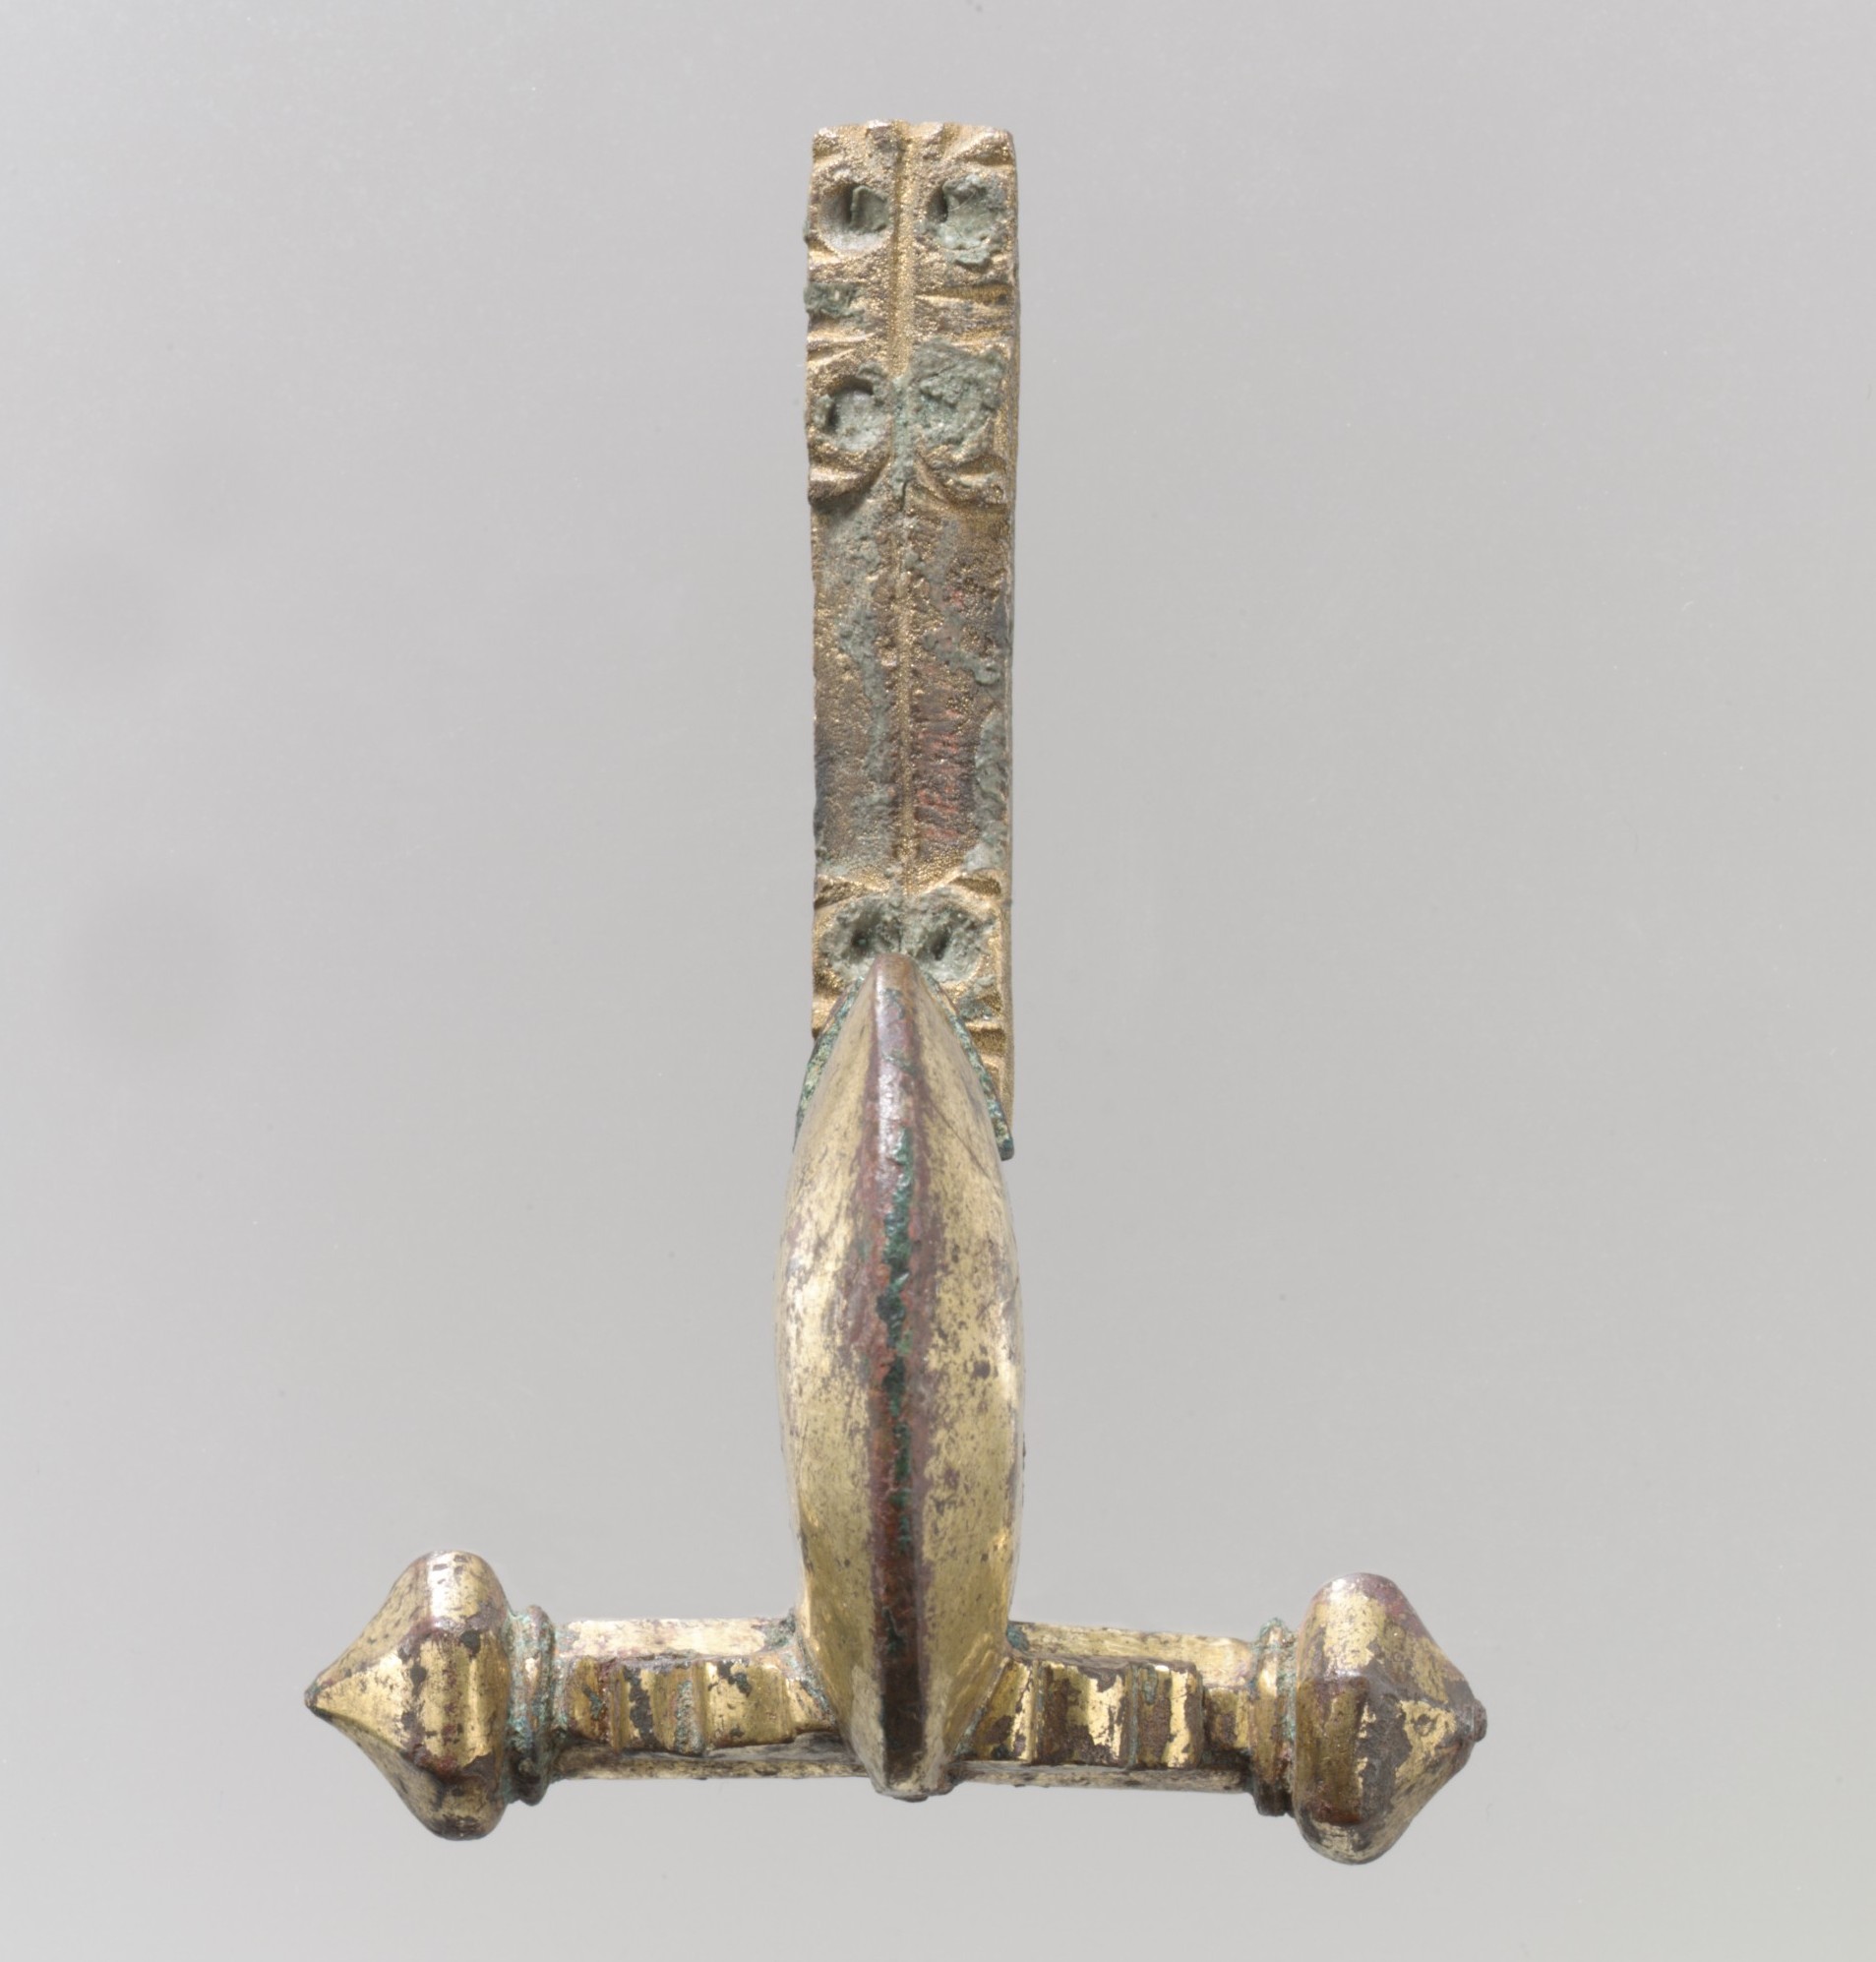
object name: brooch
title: Crossbow Brooch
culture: roman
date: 301-400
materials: bronze, gilt